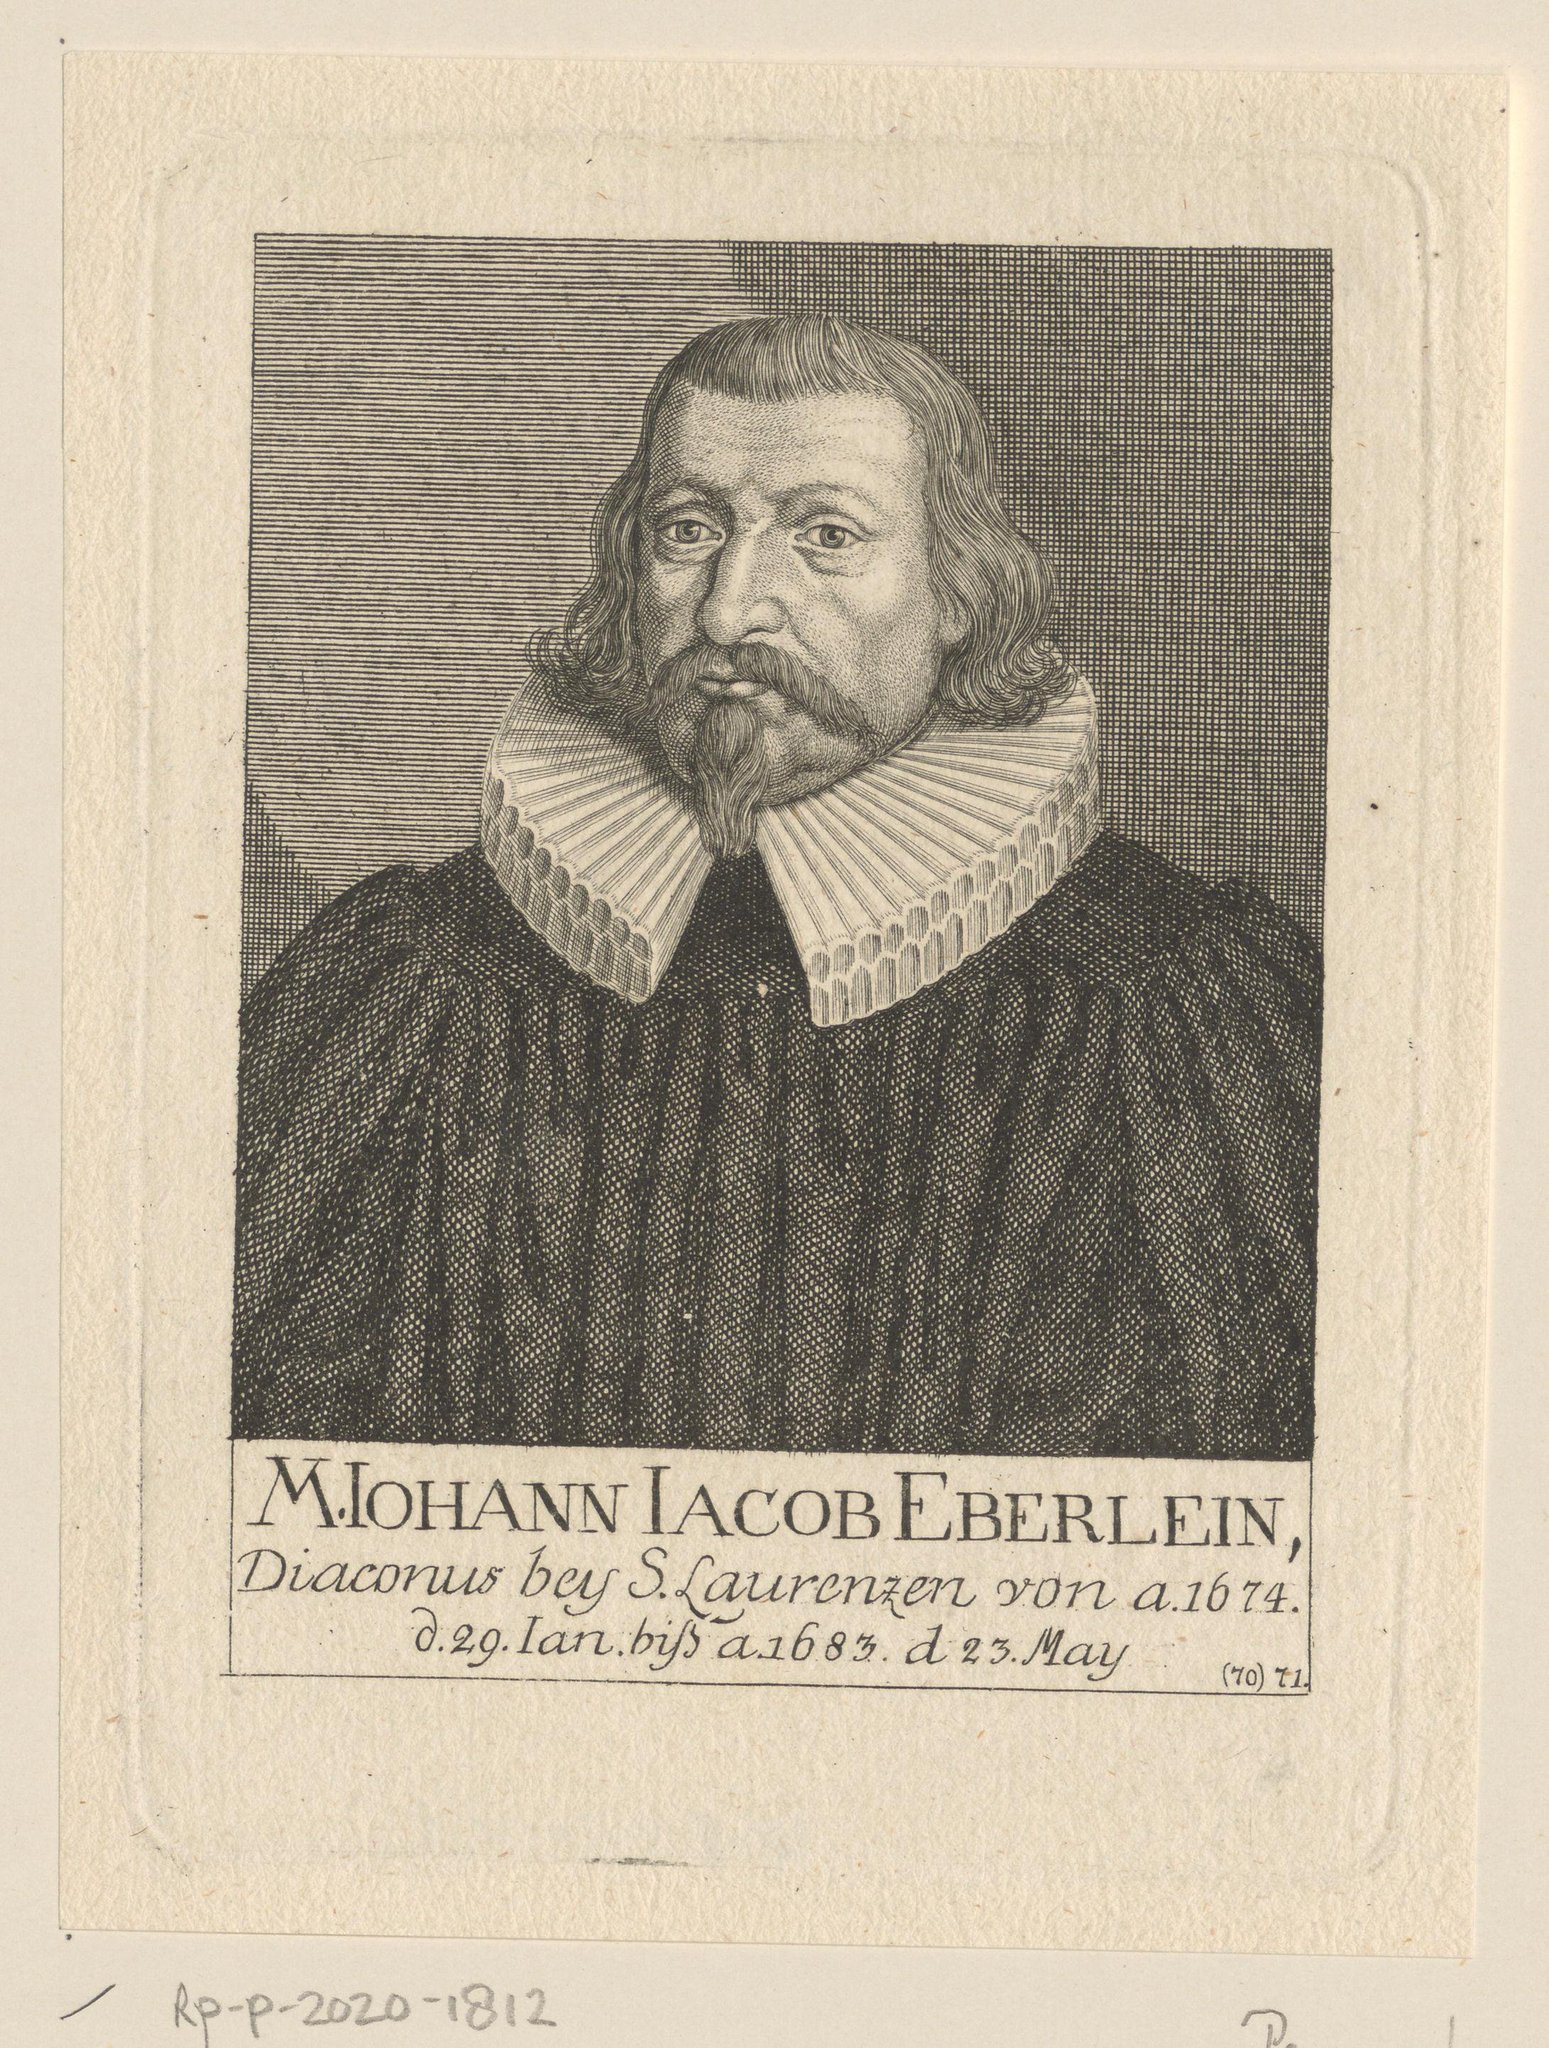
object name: print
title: Portret van Johann Jacob Eberlein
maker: Anonymous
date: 1700-1780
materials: paper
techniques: engraving, etching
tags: historical persons